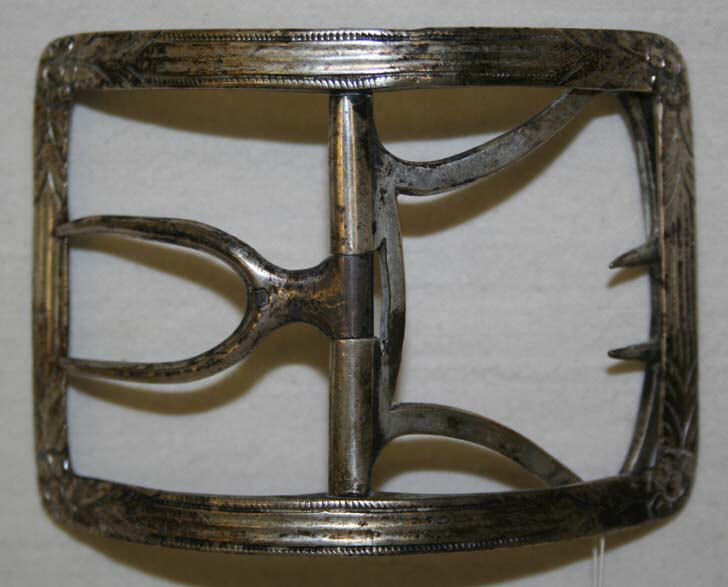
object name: shoe buckle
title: Shoe buckles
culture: british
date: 1793-1794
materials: metal